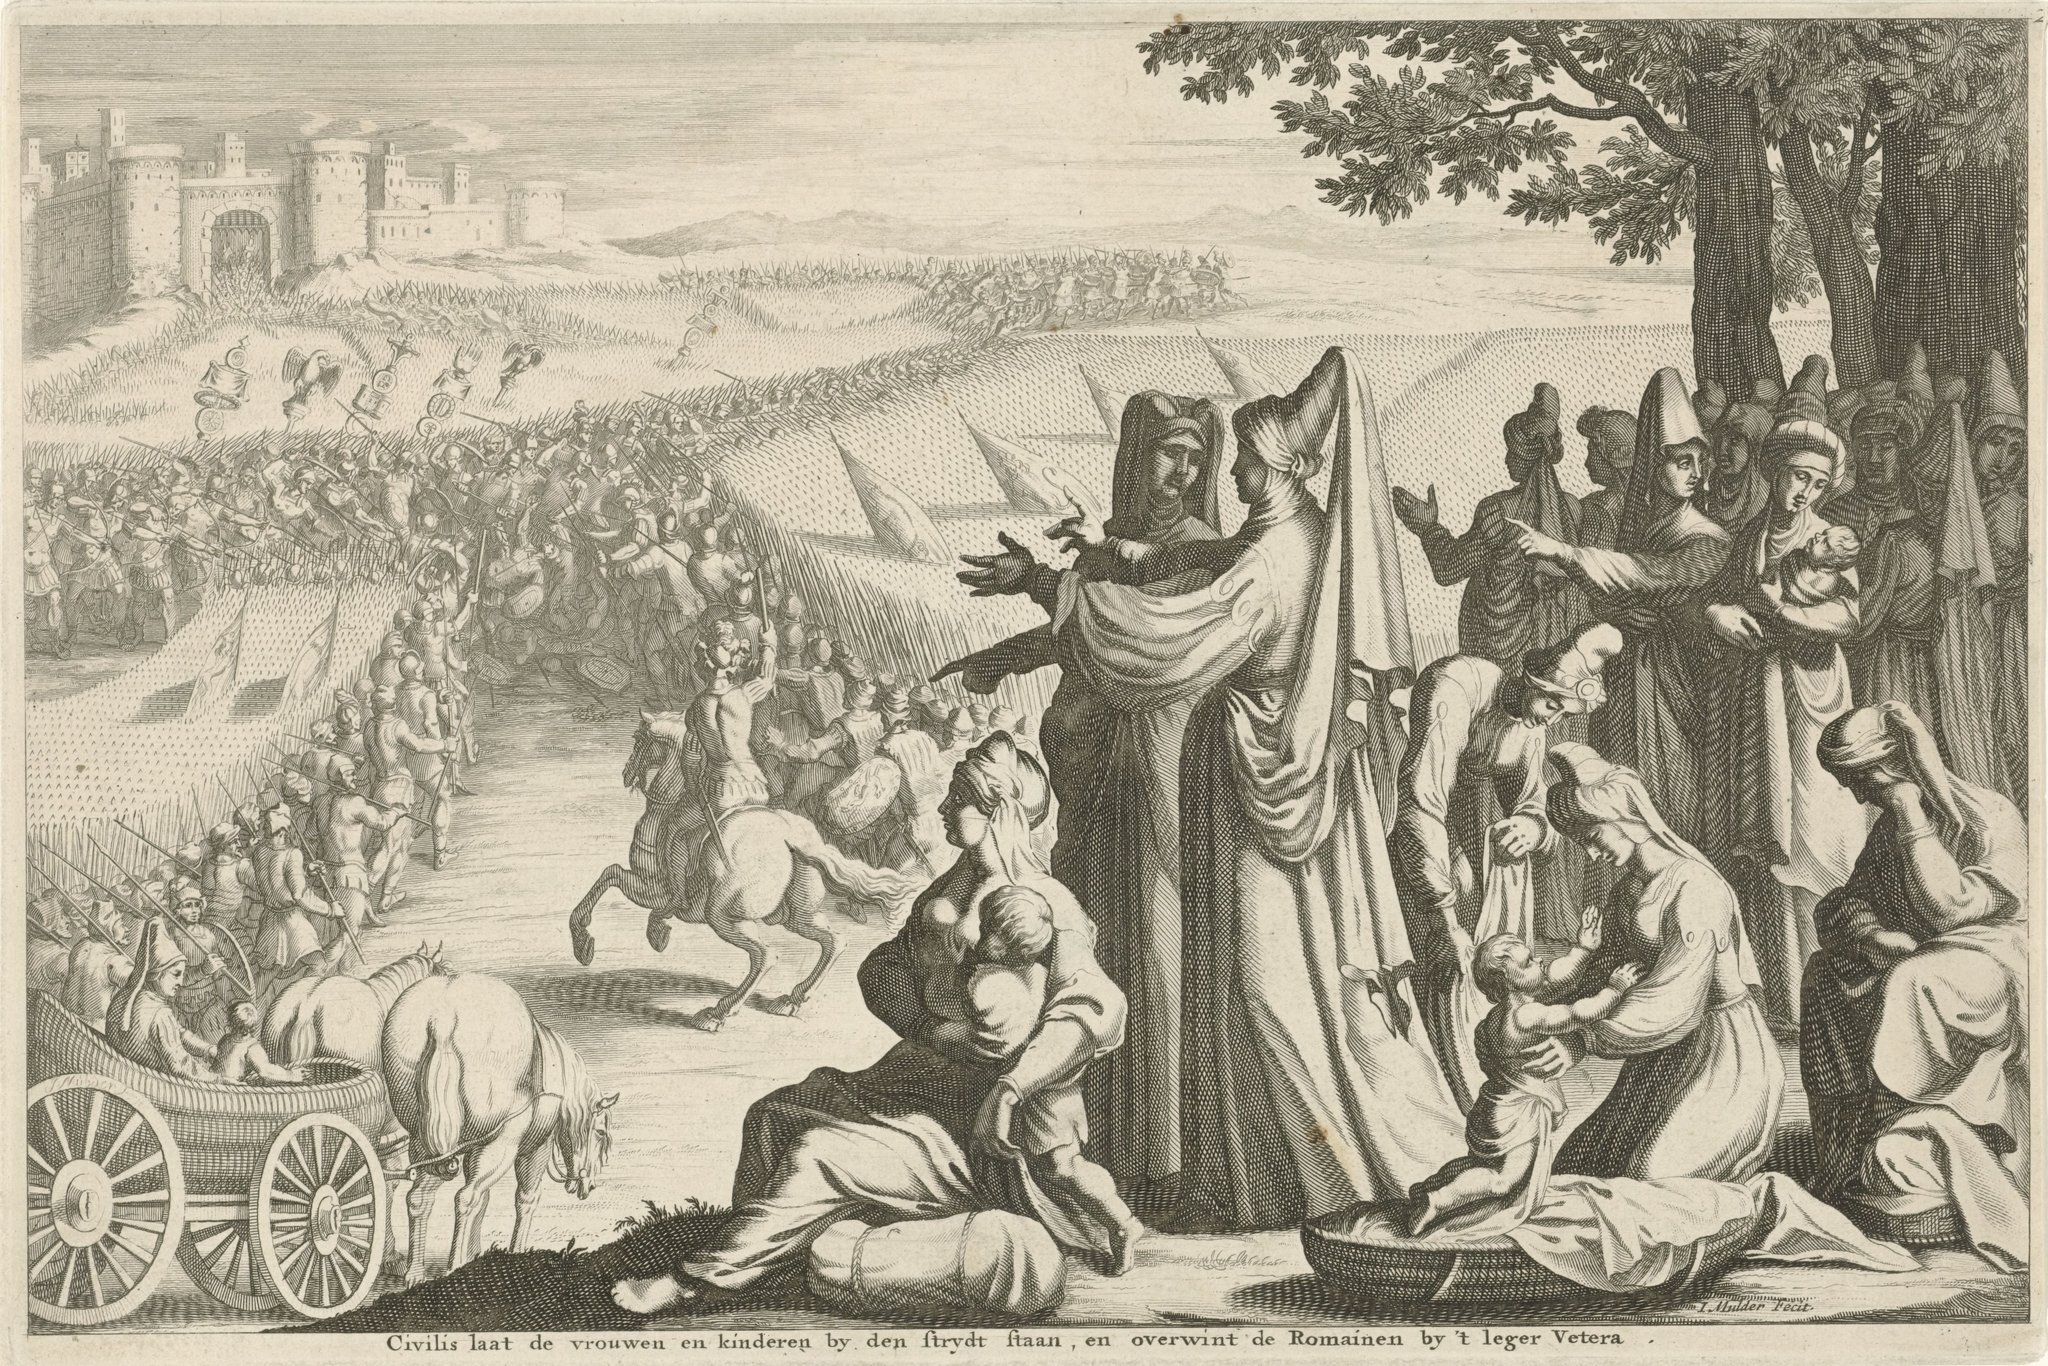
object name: book illustration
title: Vrouwen en kinderen zien toe hoe Civilis slag levert met de Romeinen, 69-70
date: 1684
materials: paper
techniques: engraving, etching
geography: amsterdam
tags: (story of) julius claudius civilis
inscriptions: collector's mark: Lugt 2228, collector's mark: Lugt 2760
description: Prent uit: Tacitus, Cornelius. Jaarboeken en Historien (...). [Vertaald uit het Latijn door] Pieter Corneliszoon Hooft. Amsterdam: Jacob de Jonge (wed.), Dirk Boom (wed.) en Hendrick Boom, 1684.